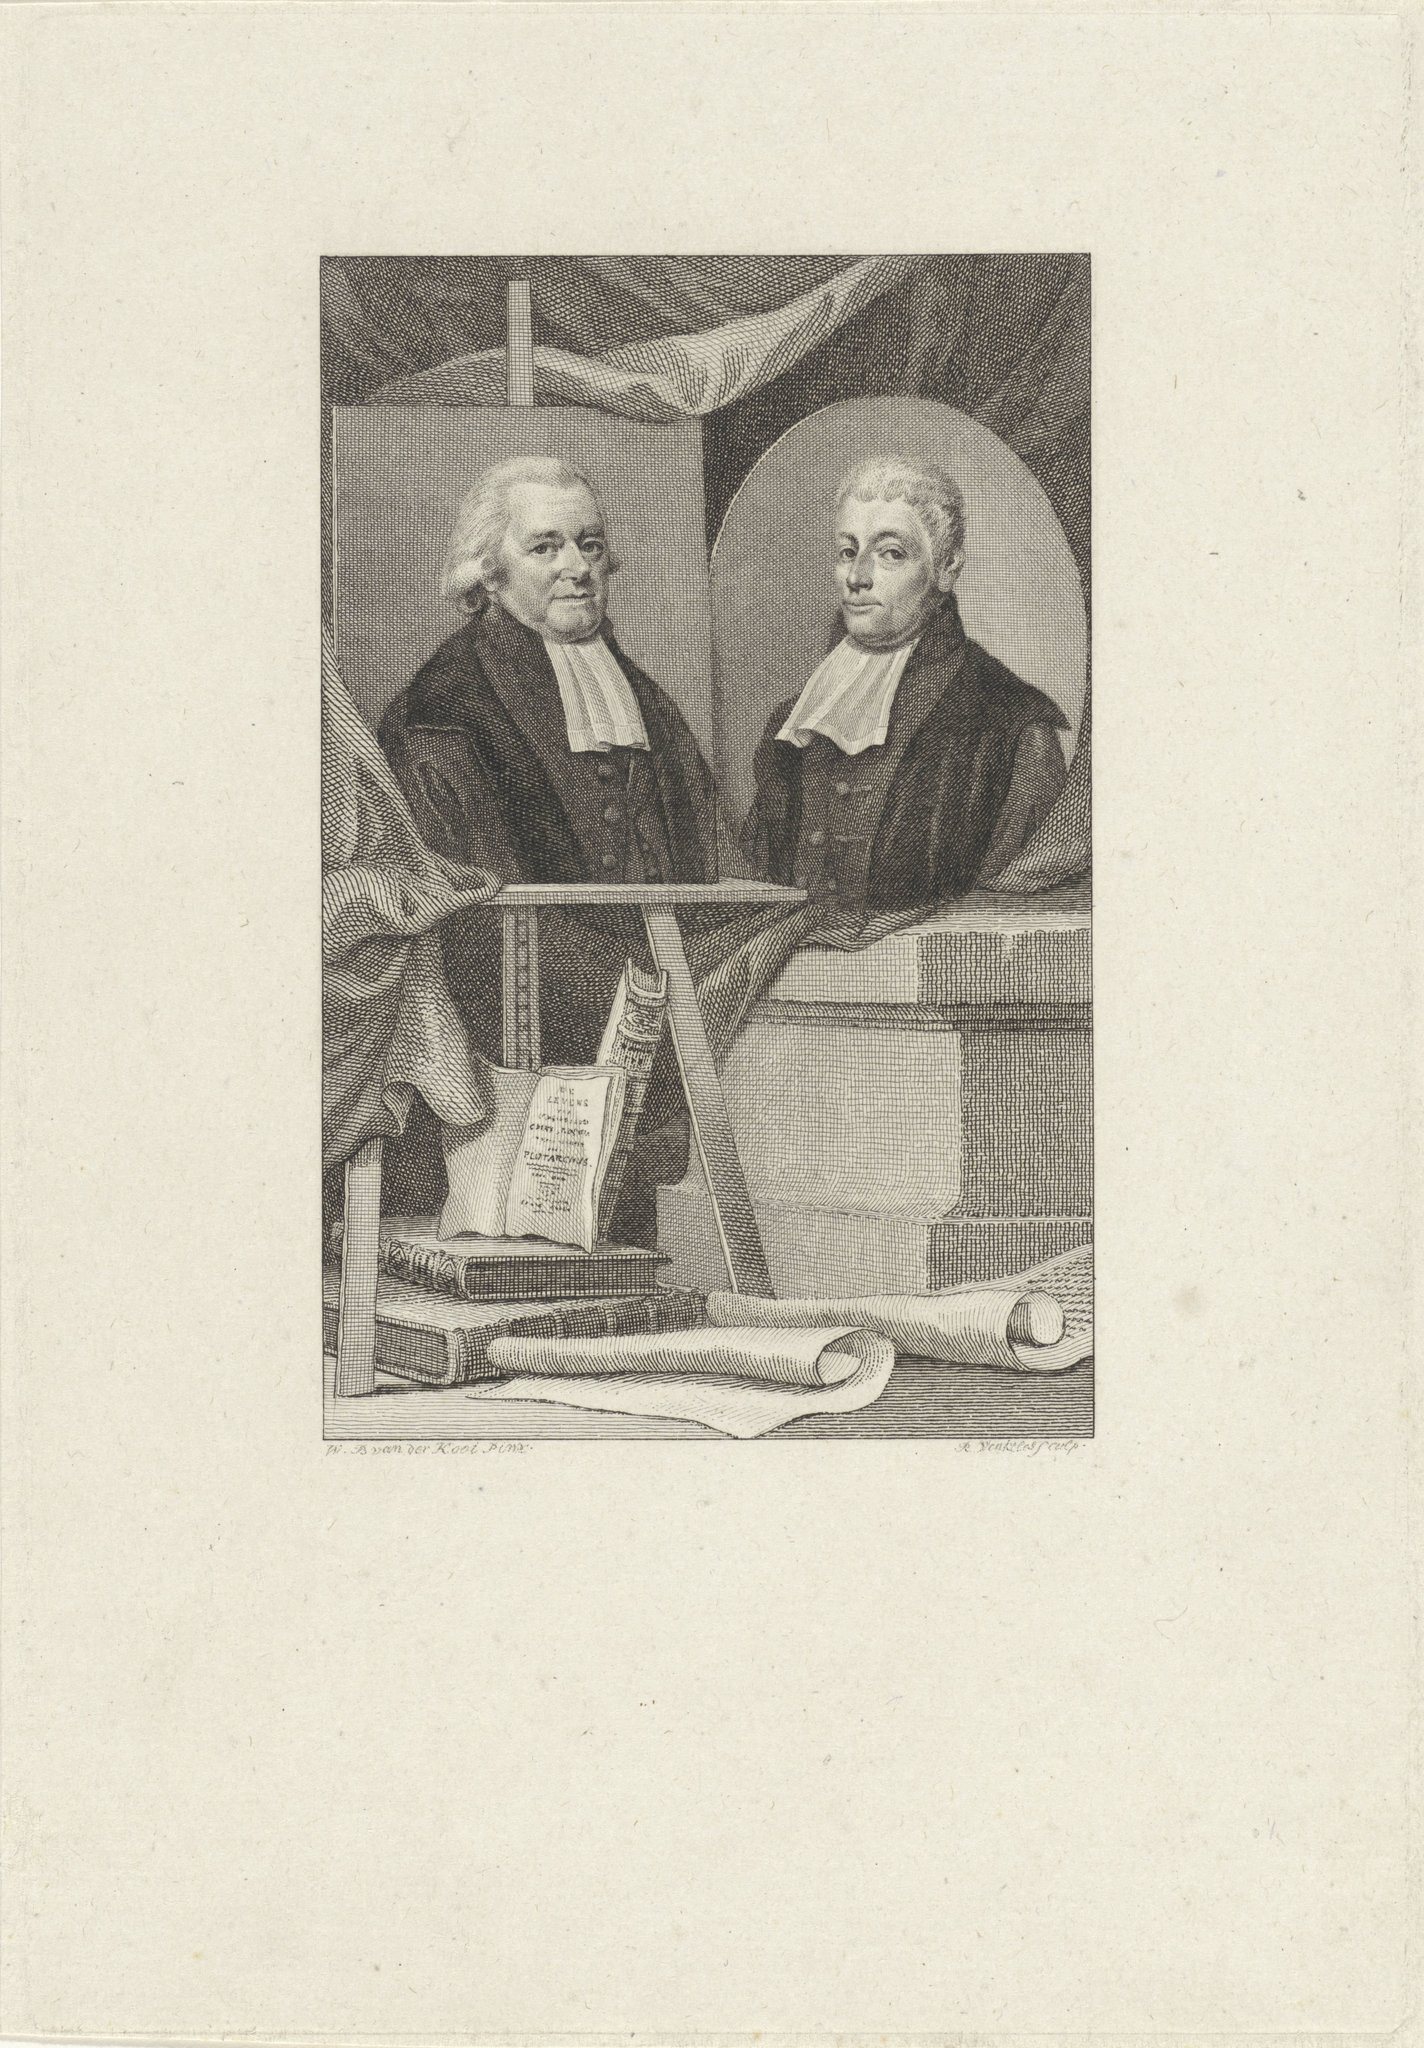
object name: print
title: Portretten van de schrijvers Everwinus Wassenbergh en Herman Bosscha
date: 1789-1816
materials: paper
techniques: engraving, etching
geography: amsterdam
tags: everwinus wassenbergh, easel, paper (writing material)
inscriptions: collector's mark: Lugt 2228